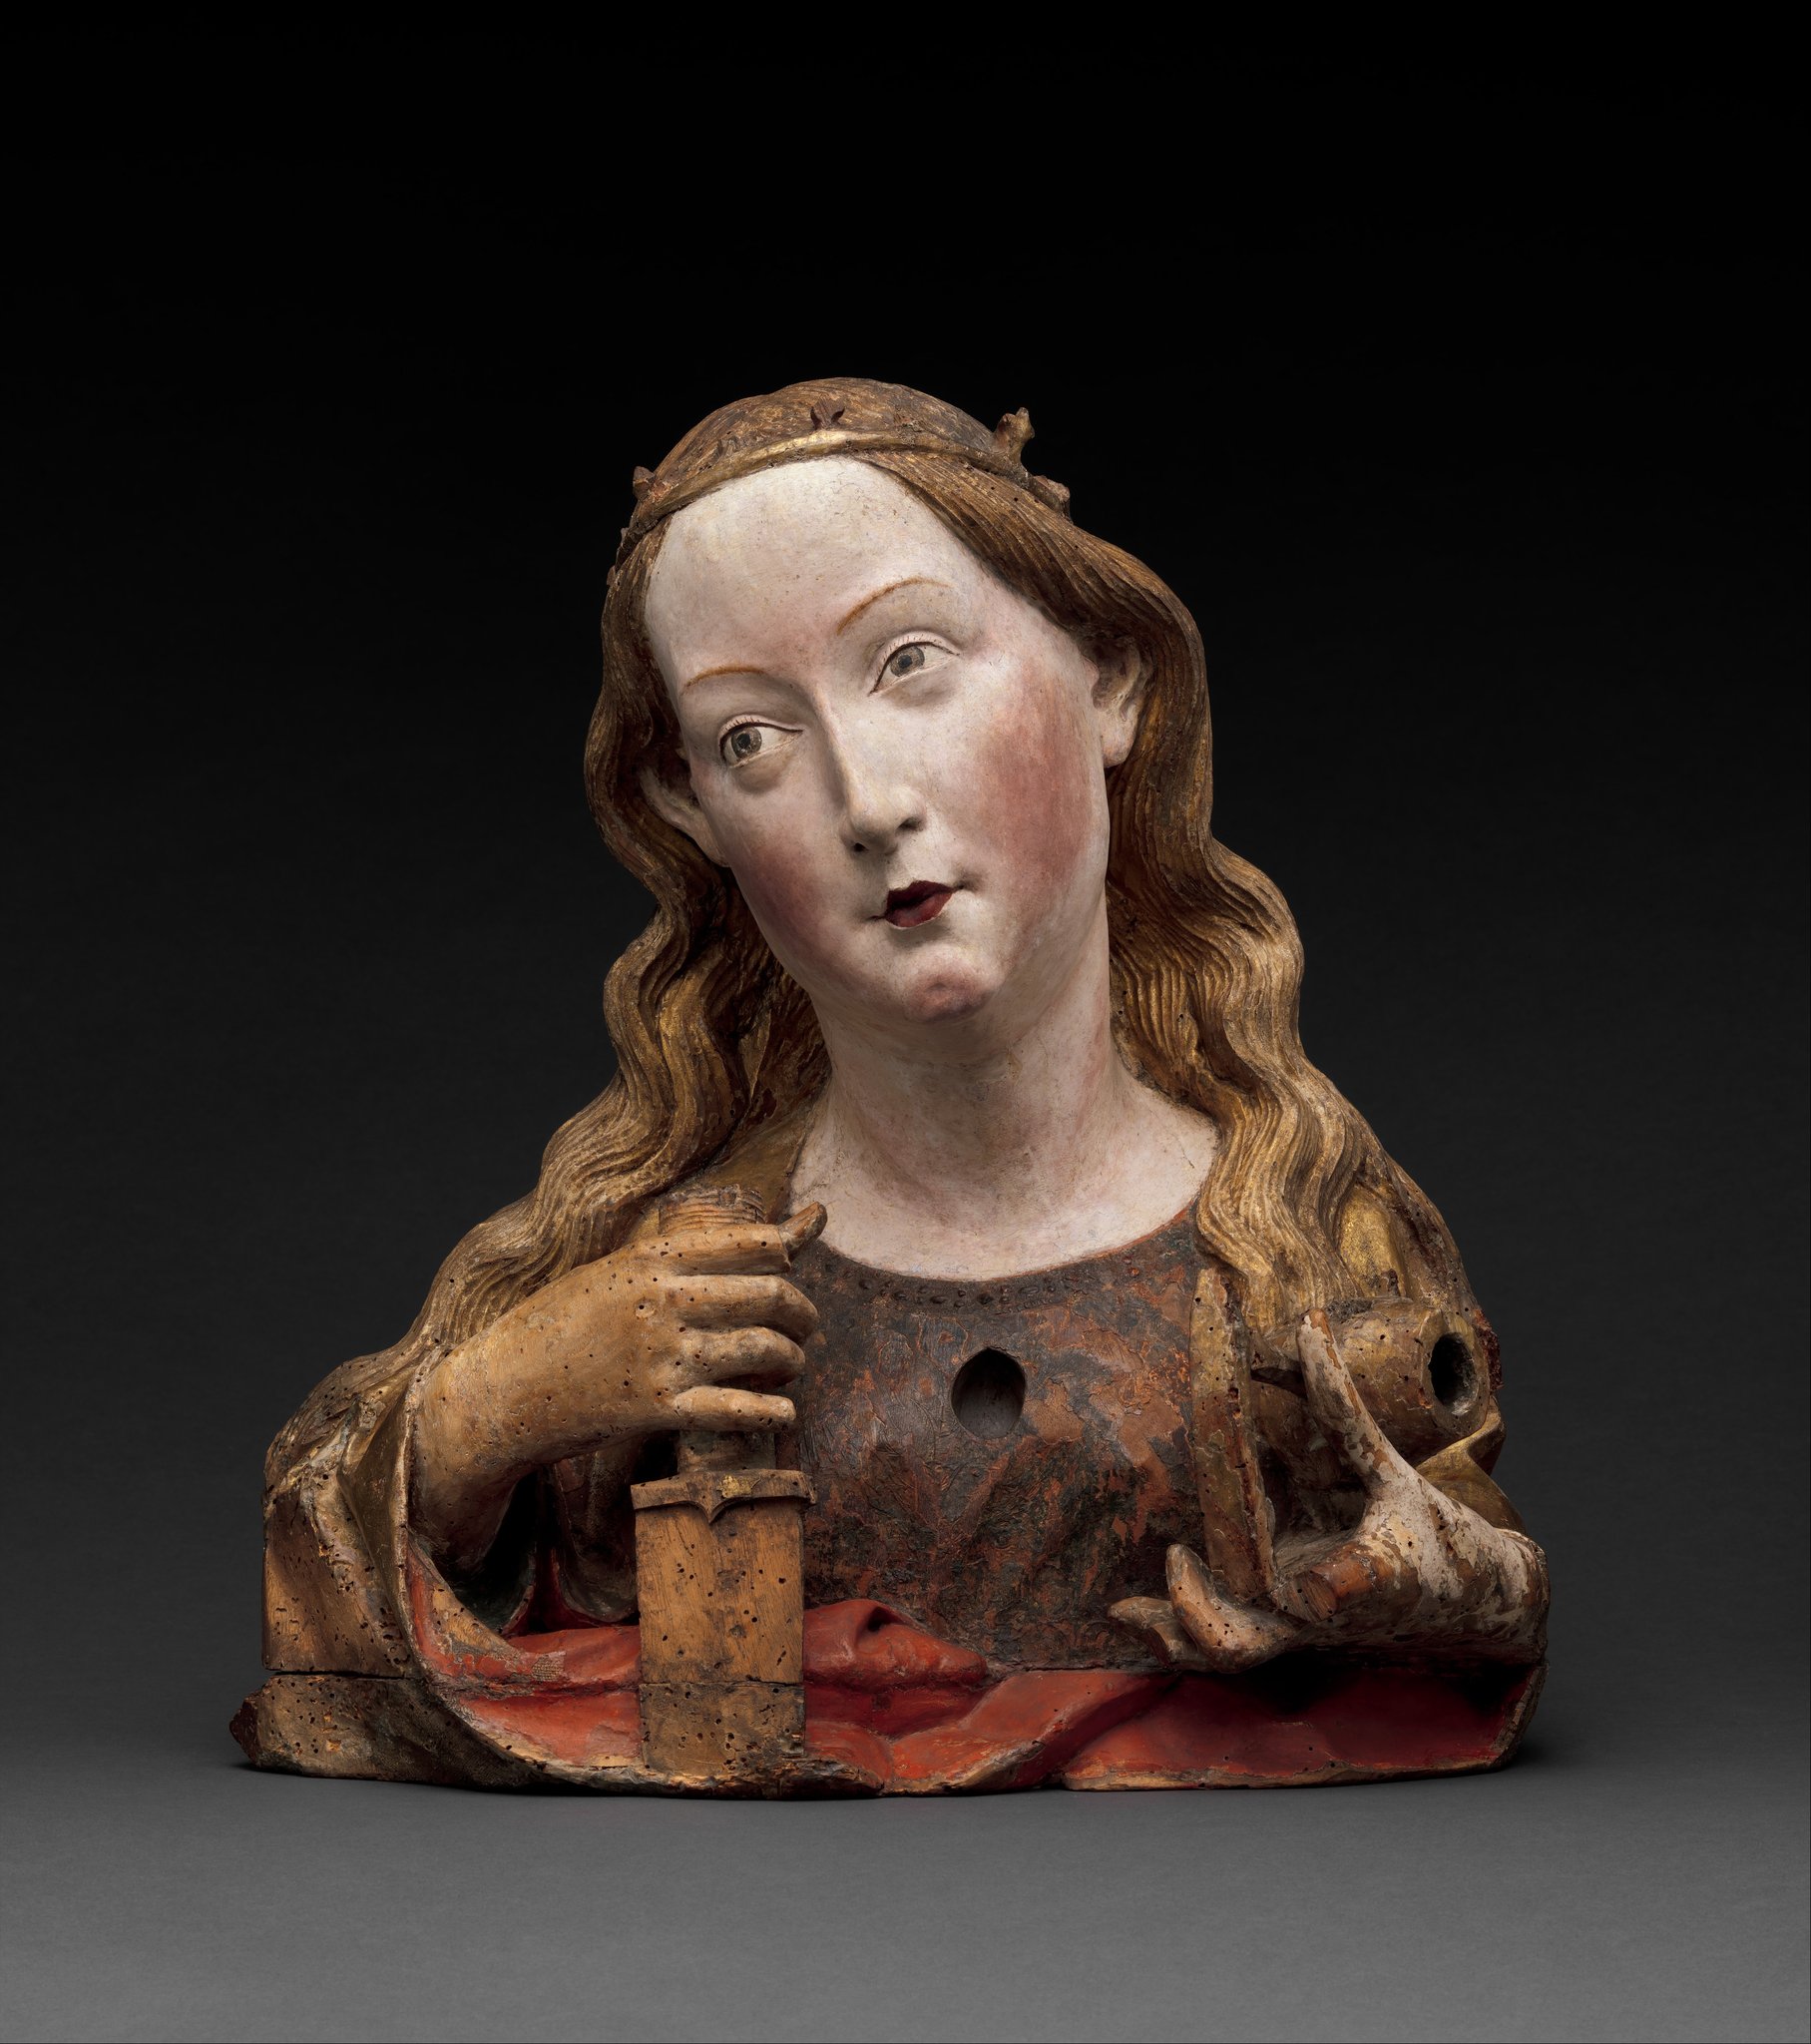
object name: reliquary bust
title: Reliquary Bust of Saint Catherine of Alexandria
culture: german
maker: niclaus gerhaert von leyden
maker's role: artist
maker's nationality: north netherlandish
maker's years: 1462-1473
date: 1465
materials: paint, wood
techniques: gilding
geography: germany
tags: saint catherine